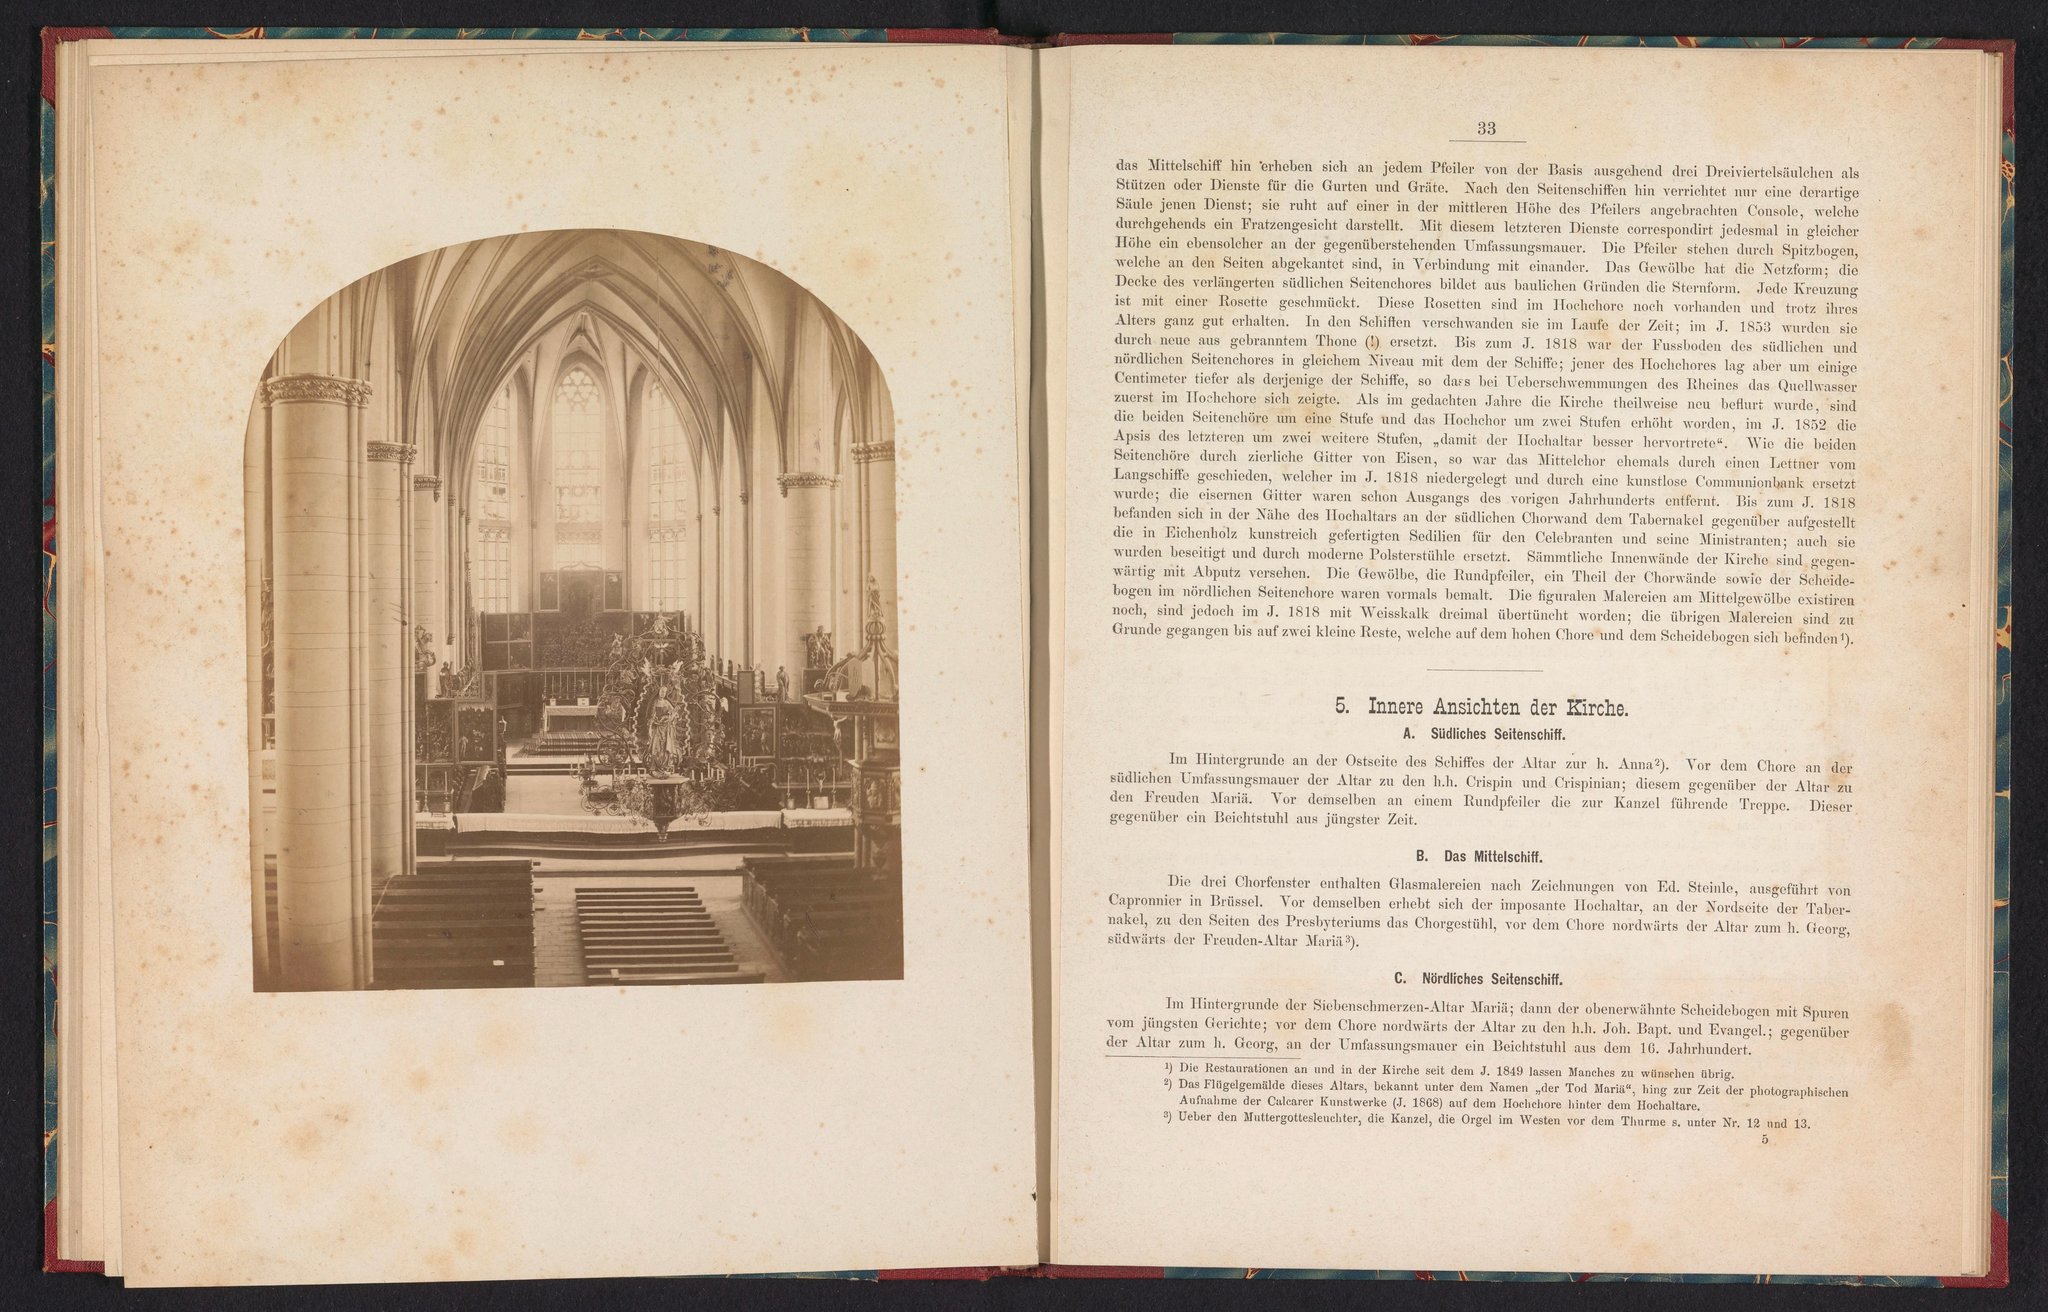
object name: page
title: Interieur van de Sint-Nicolaaskerk in Kalkar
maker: friedrich brandt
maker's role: fotograaf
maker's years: 1823-1891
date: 1870-1880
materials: photographic support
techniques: albumen print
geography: kalkar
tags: interior of church, parts of church interior: choir